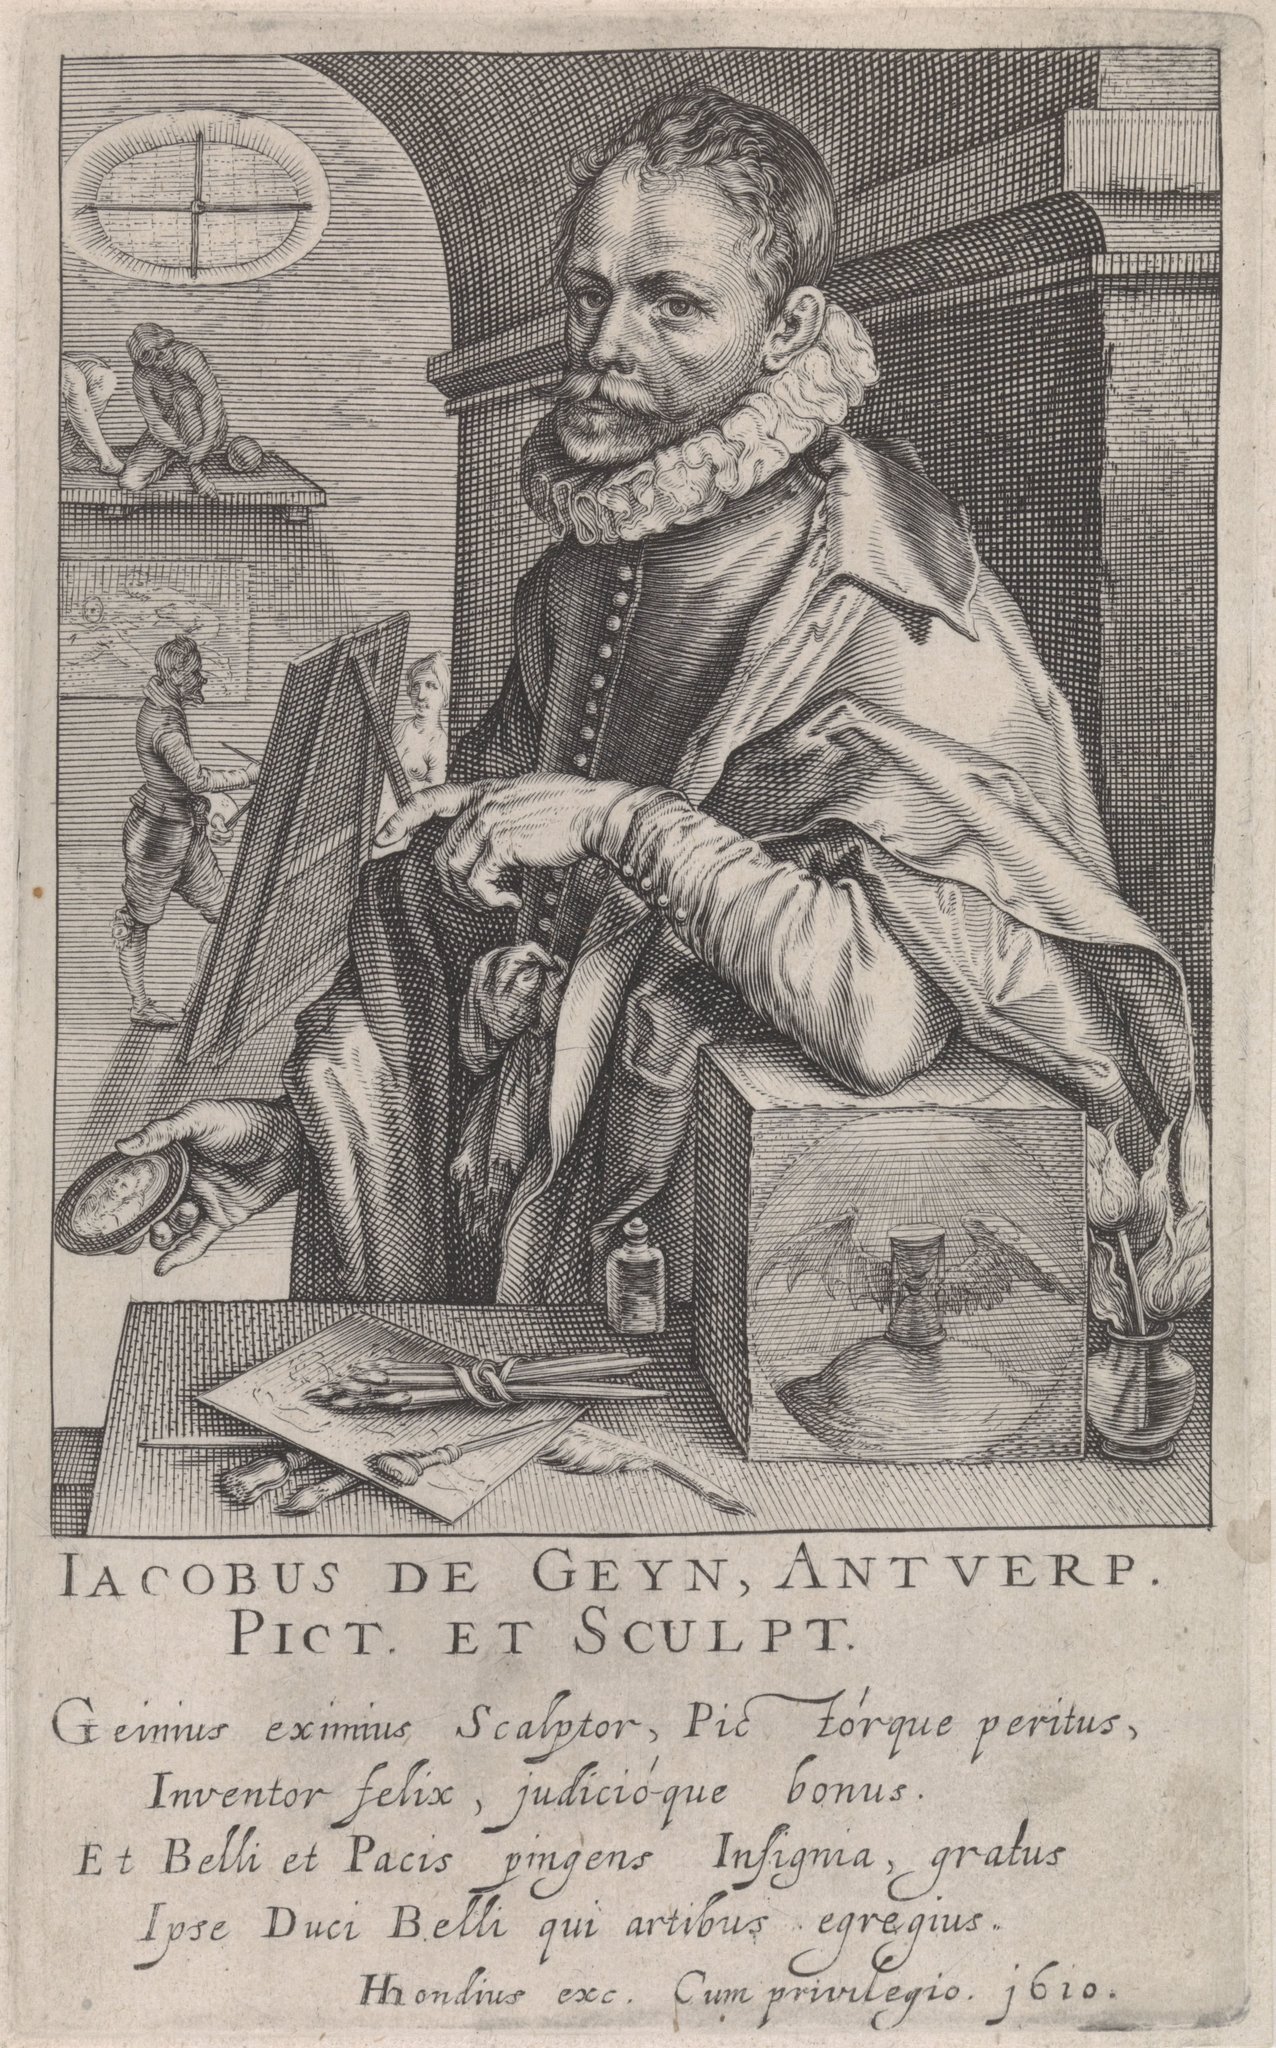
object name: print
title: Pictorum aliquot celebrium praecipuae Germaniae Inferioris effigies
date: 1610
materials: paper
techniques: engraving, etching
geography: the hague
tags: antwerp, the hague, painter, print maker, jacques de gheyn (ii), portrait, self-portrait of painter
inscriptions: collector's mark: Lugt 2228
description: Portret ten halven lijve naar links van Jacob de Geyn. Onder het portret zijn naam en vier regels in het Latijn. Prent uit deel 3 van de serie Pictorum Aliquot Celebrium Praecipuae Germaniae Inferioris Effigies. Serie van 72 kunstenaarsportretten vervaardigd door Hendrick Hondius I, Simon Frisius, Andries Jacobsz. Stock en Robert de Baudous.